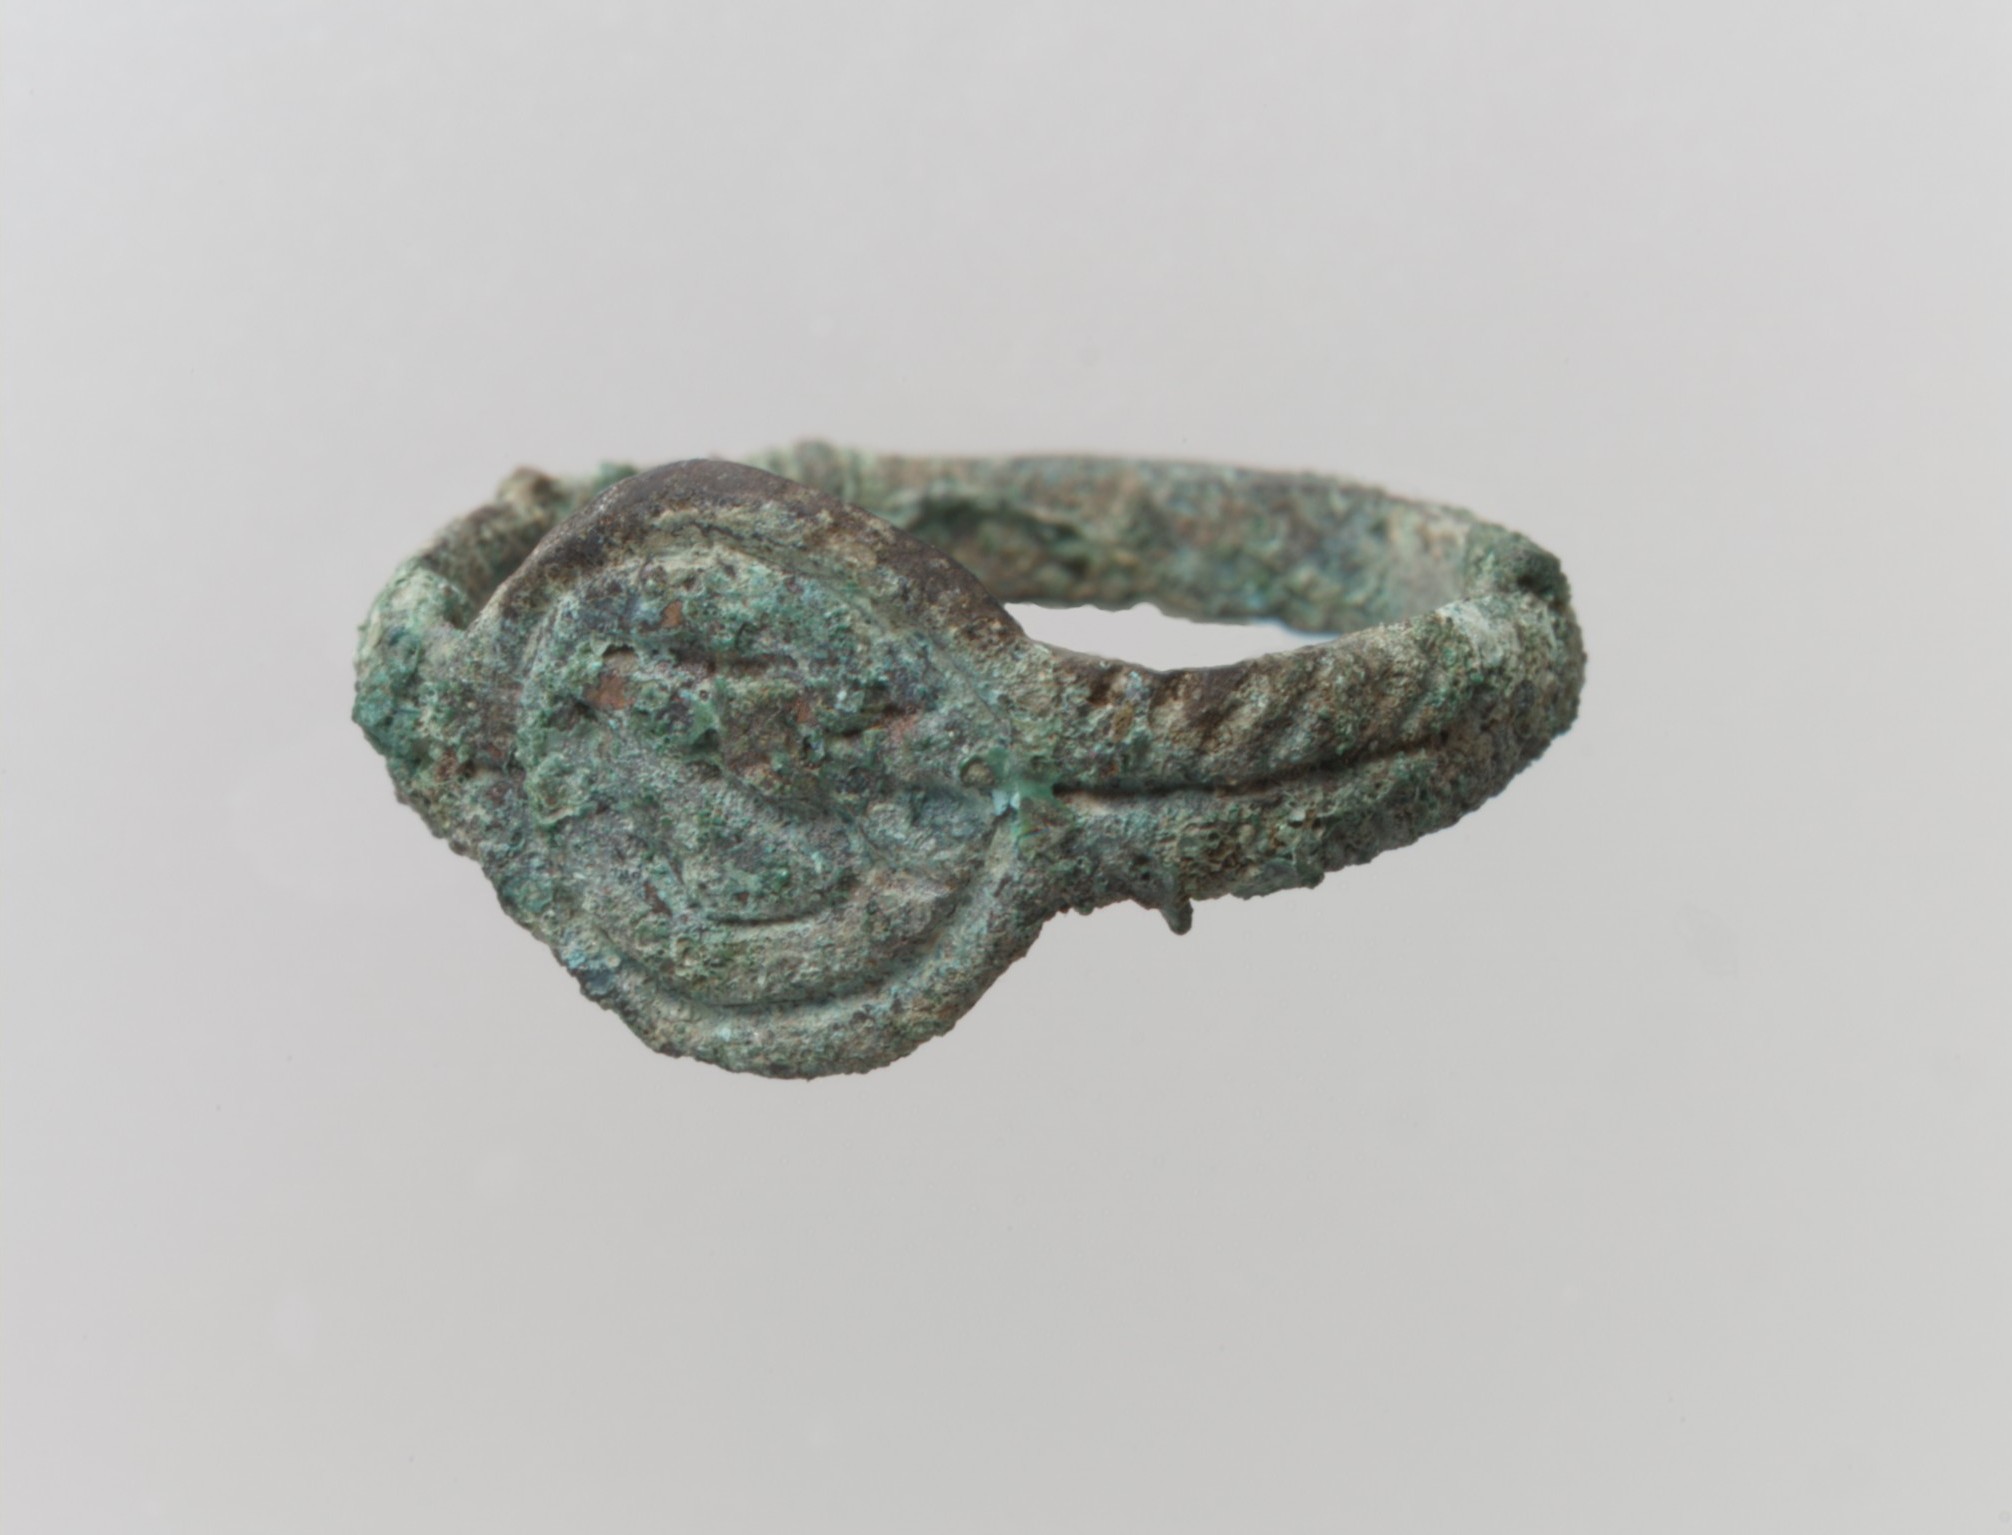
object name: ring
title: Finger Ring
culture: frankish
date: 601-700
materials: copper alloy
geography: germany